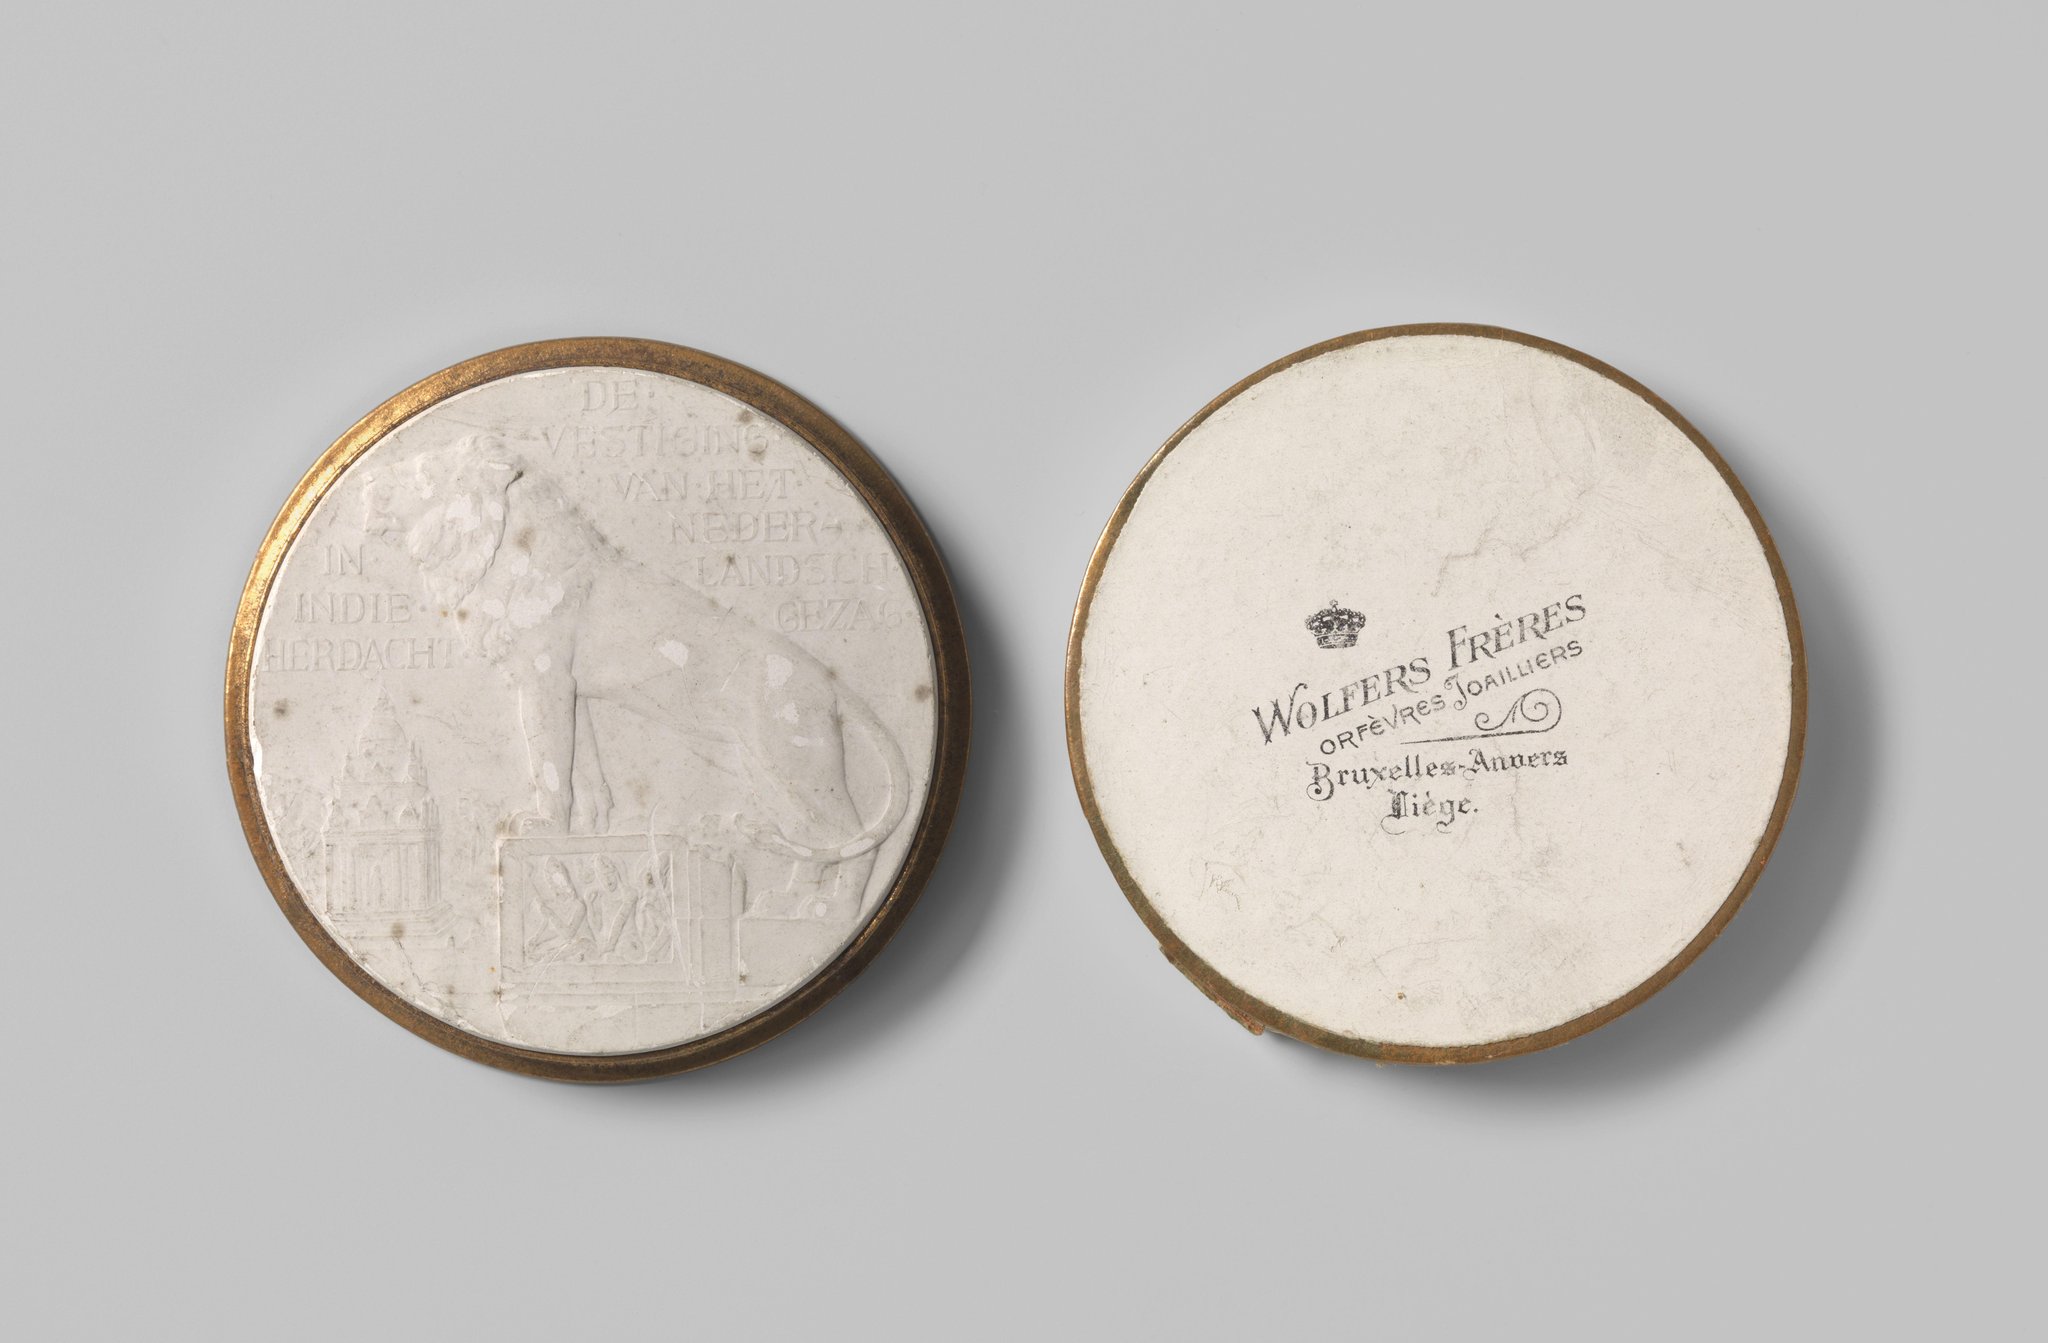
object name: design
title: De vestiging van het Nederlands gezag in Indië herdacht, 1902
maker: johan melchior faddegon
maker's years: 1871-1941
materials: gypsum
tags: dutch east indies, the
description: Ontwerp in gips voor de penning De vestiging van het Nederlands gezag in Indië herdacht: op Javaanse tempelresten staande (Nederlandse) leeuw, naar links gekeerd, met boeddistsche tempe,l in heuvelachtig landschap op de achtergrond, met opschrift ter weerszijden van de leeuw, in rond doosje